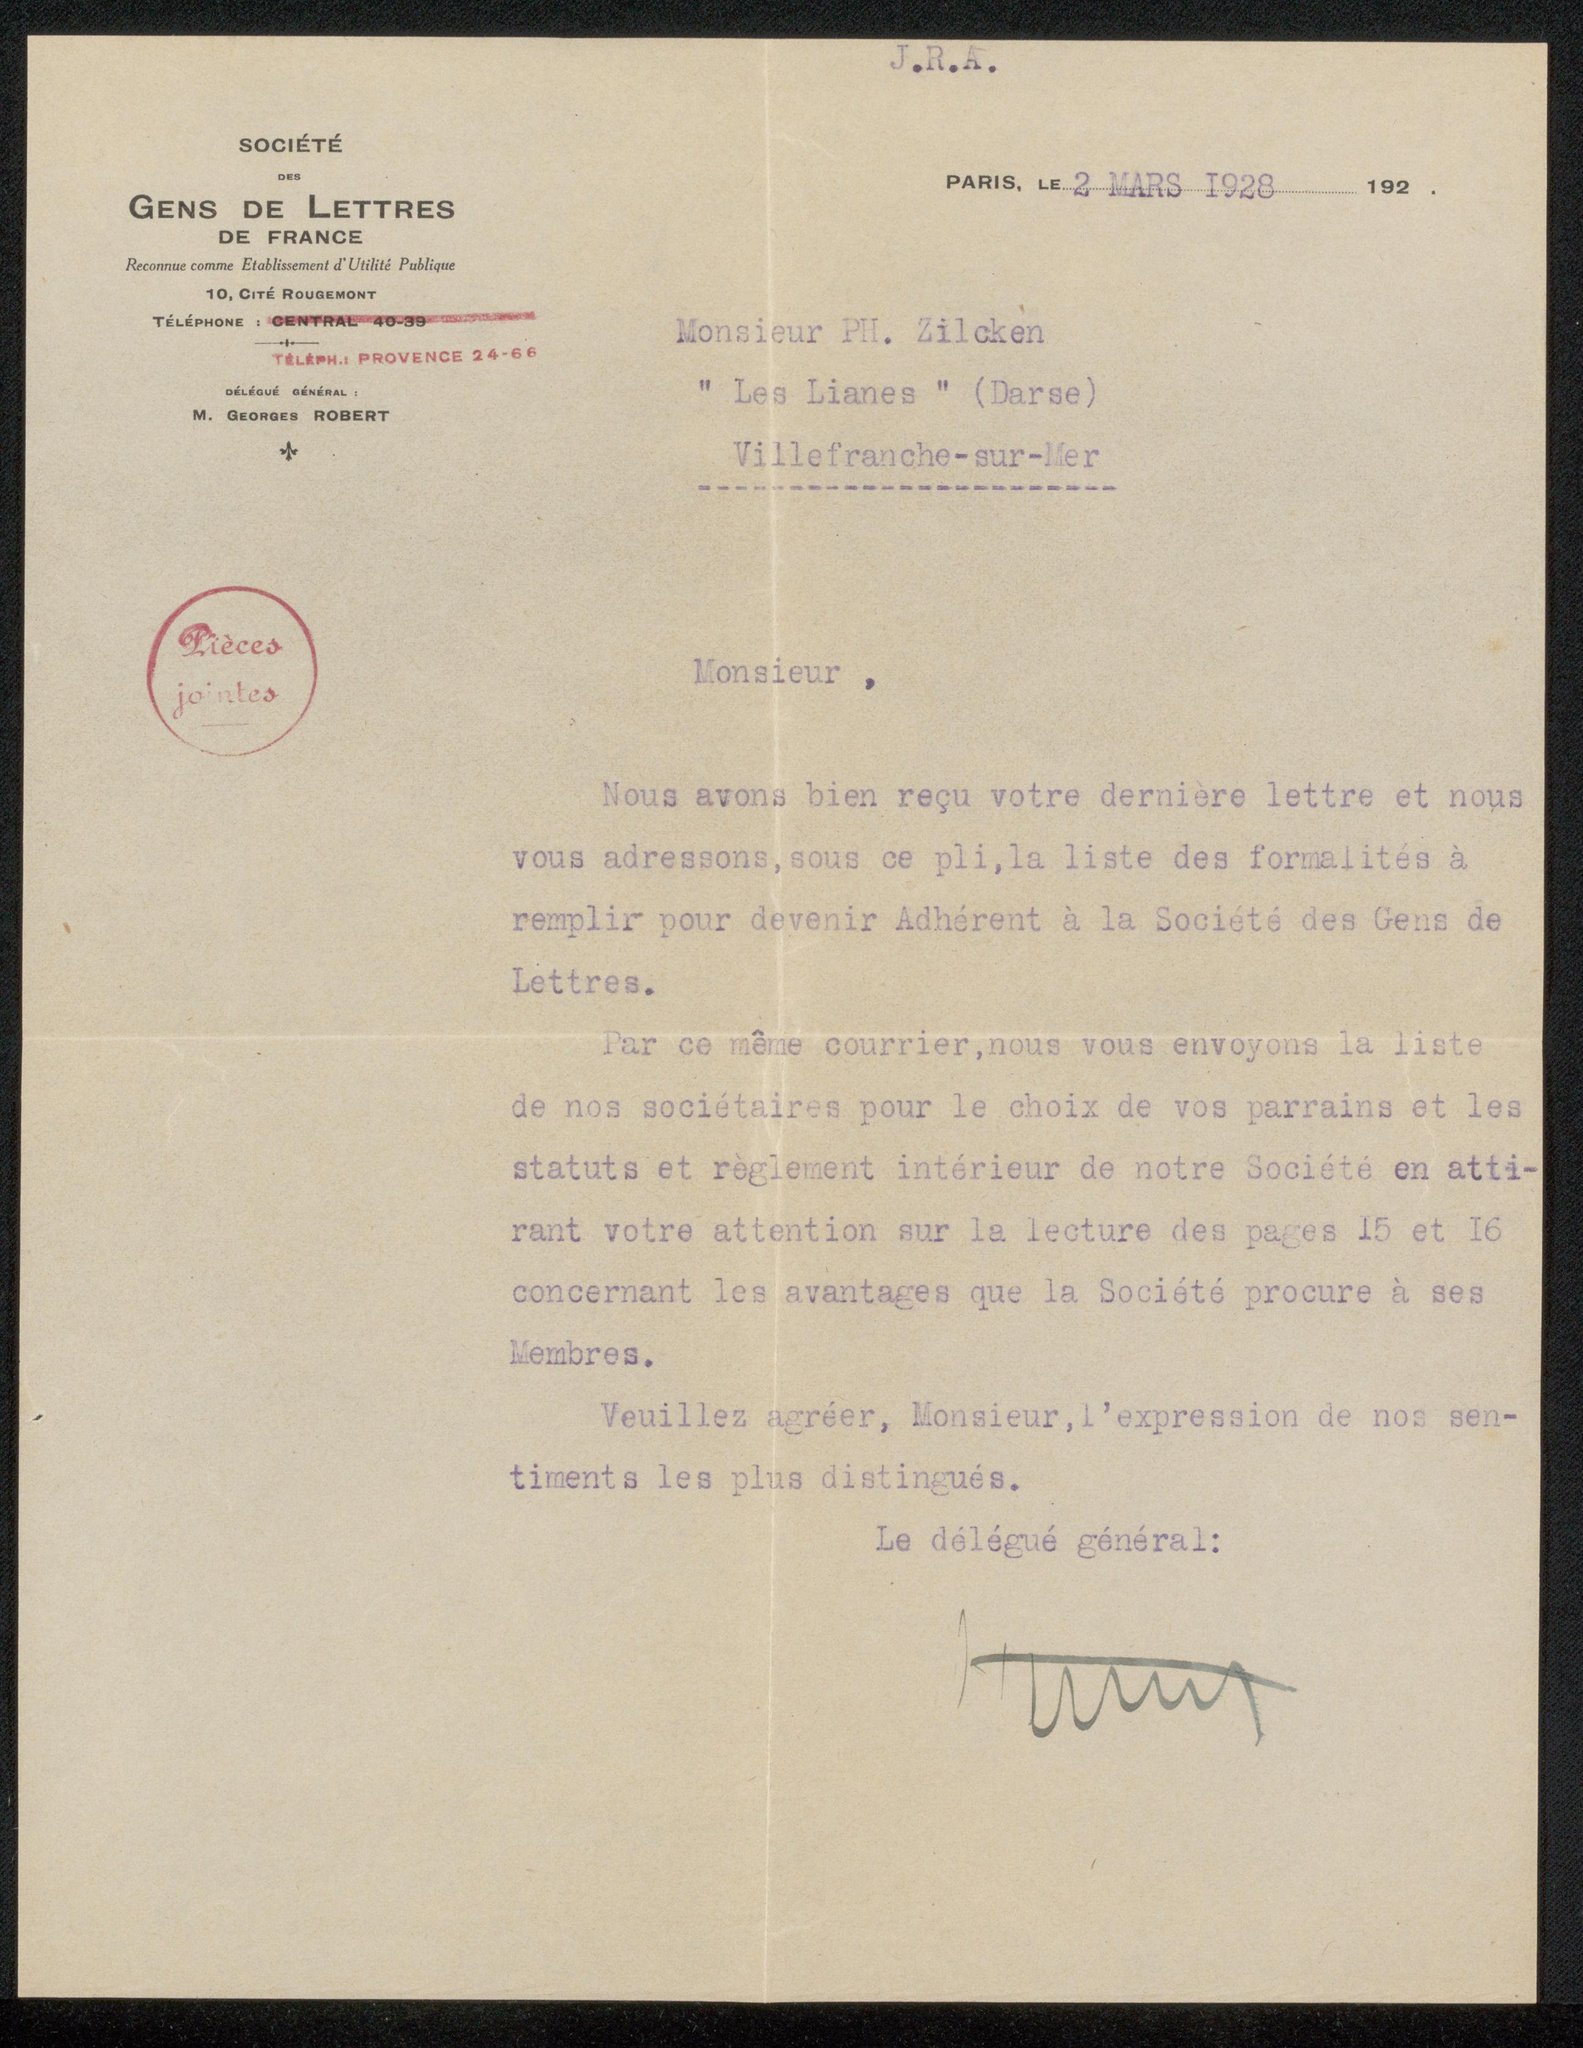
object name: letter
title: Brief aan Philip Zilcken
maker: Anonymous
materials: ink, paper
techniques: pen, printing, typewriting, writing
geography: paris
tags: draughtsman, philip zilcken